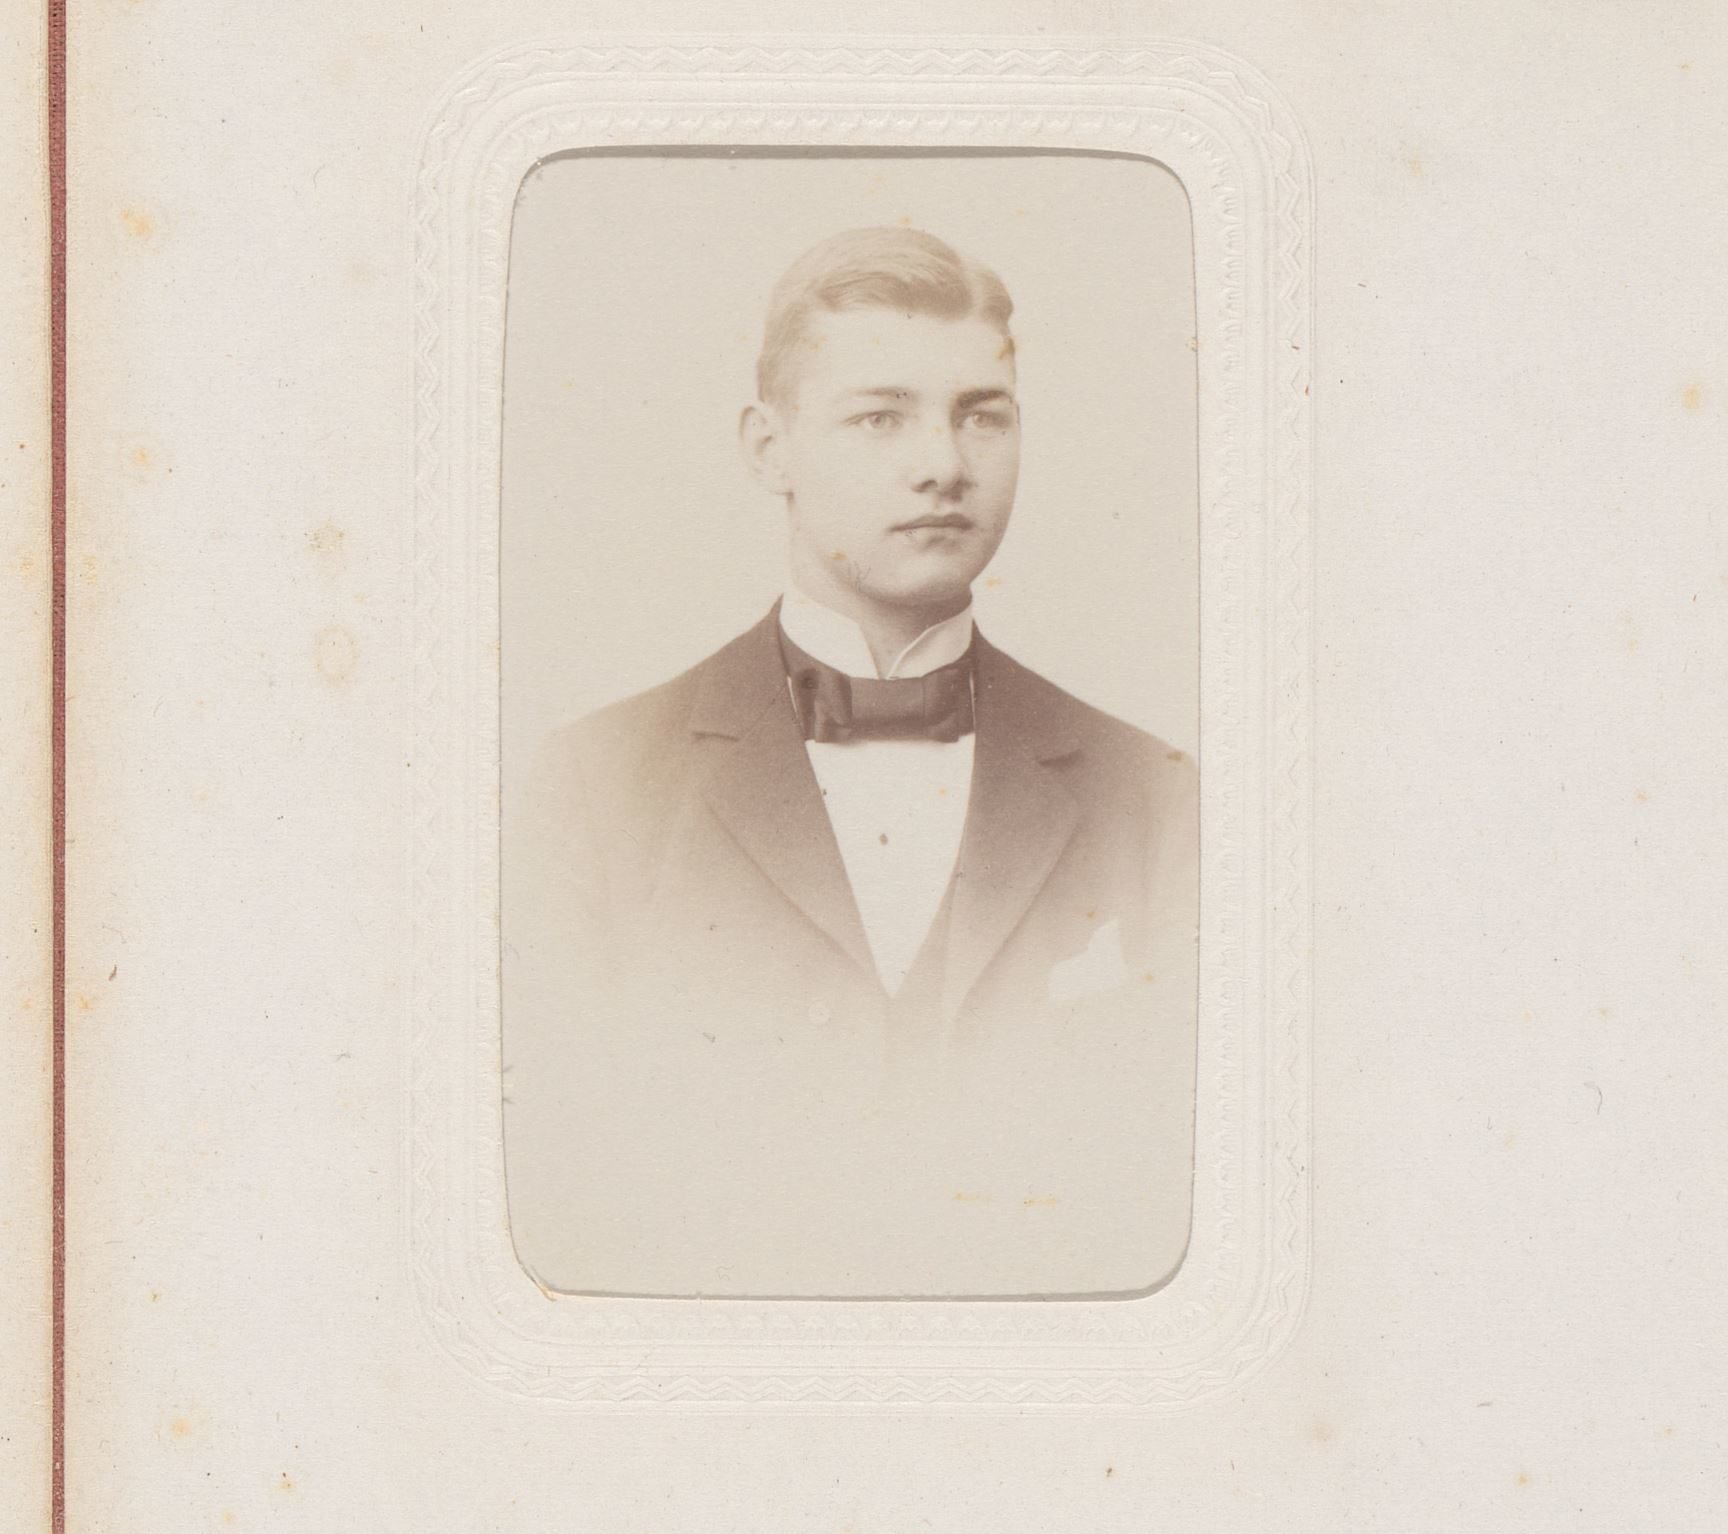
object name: album leaf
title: Portret van een jonge man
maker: h. berghäger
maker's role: fotograaf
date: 1850-1900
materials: cardboard, photographic support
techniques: albumen print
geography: bremen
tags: historical persons, youth, adolescent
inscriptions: inscription: ‘H. Berghäger/ PHOTOGRAPH/ BREMEN/ WALL 132,/ zwischen Heerden-u. Ansgariithor/ gegenüber der Blumenschule./ Die Platte bleibt für Nachbestellungen aufbewahrt./ SPECIALITÄT:/ Vergrösserungen werden nach kleinen Bilde/ sauber ausgeführt.’